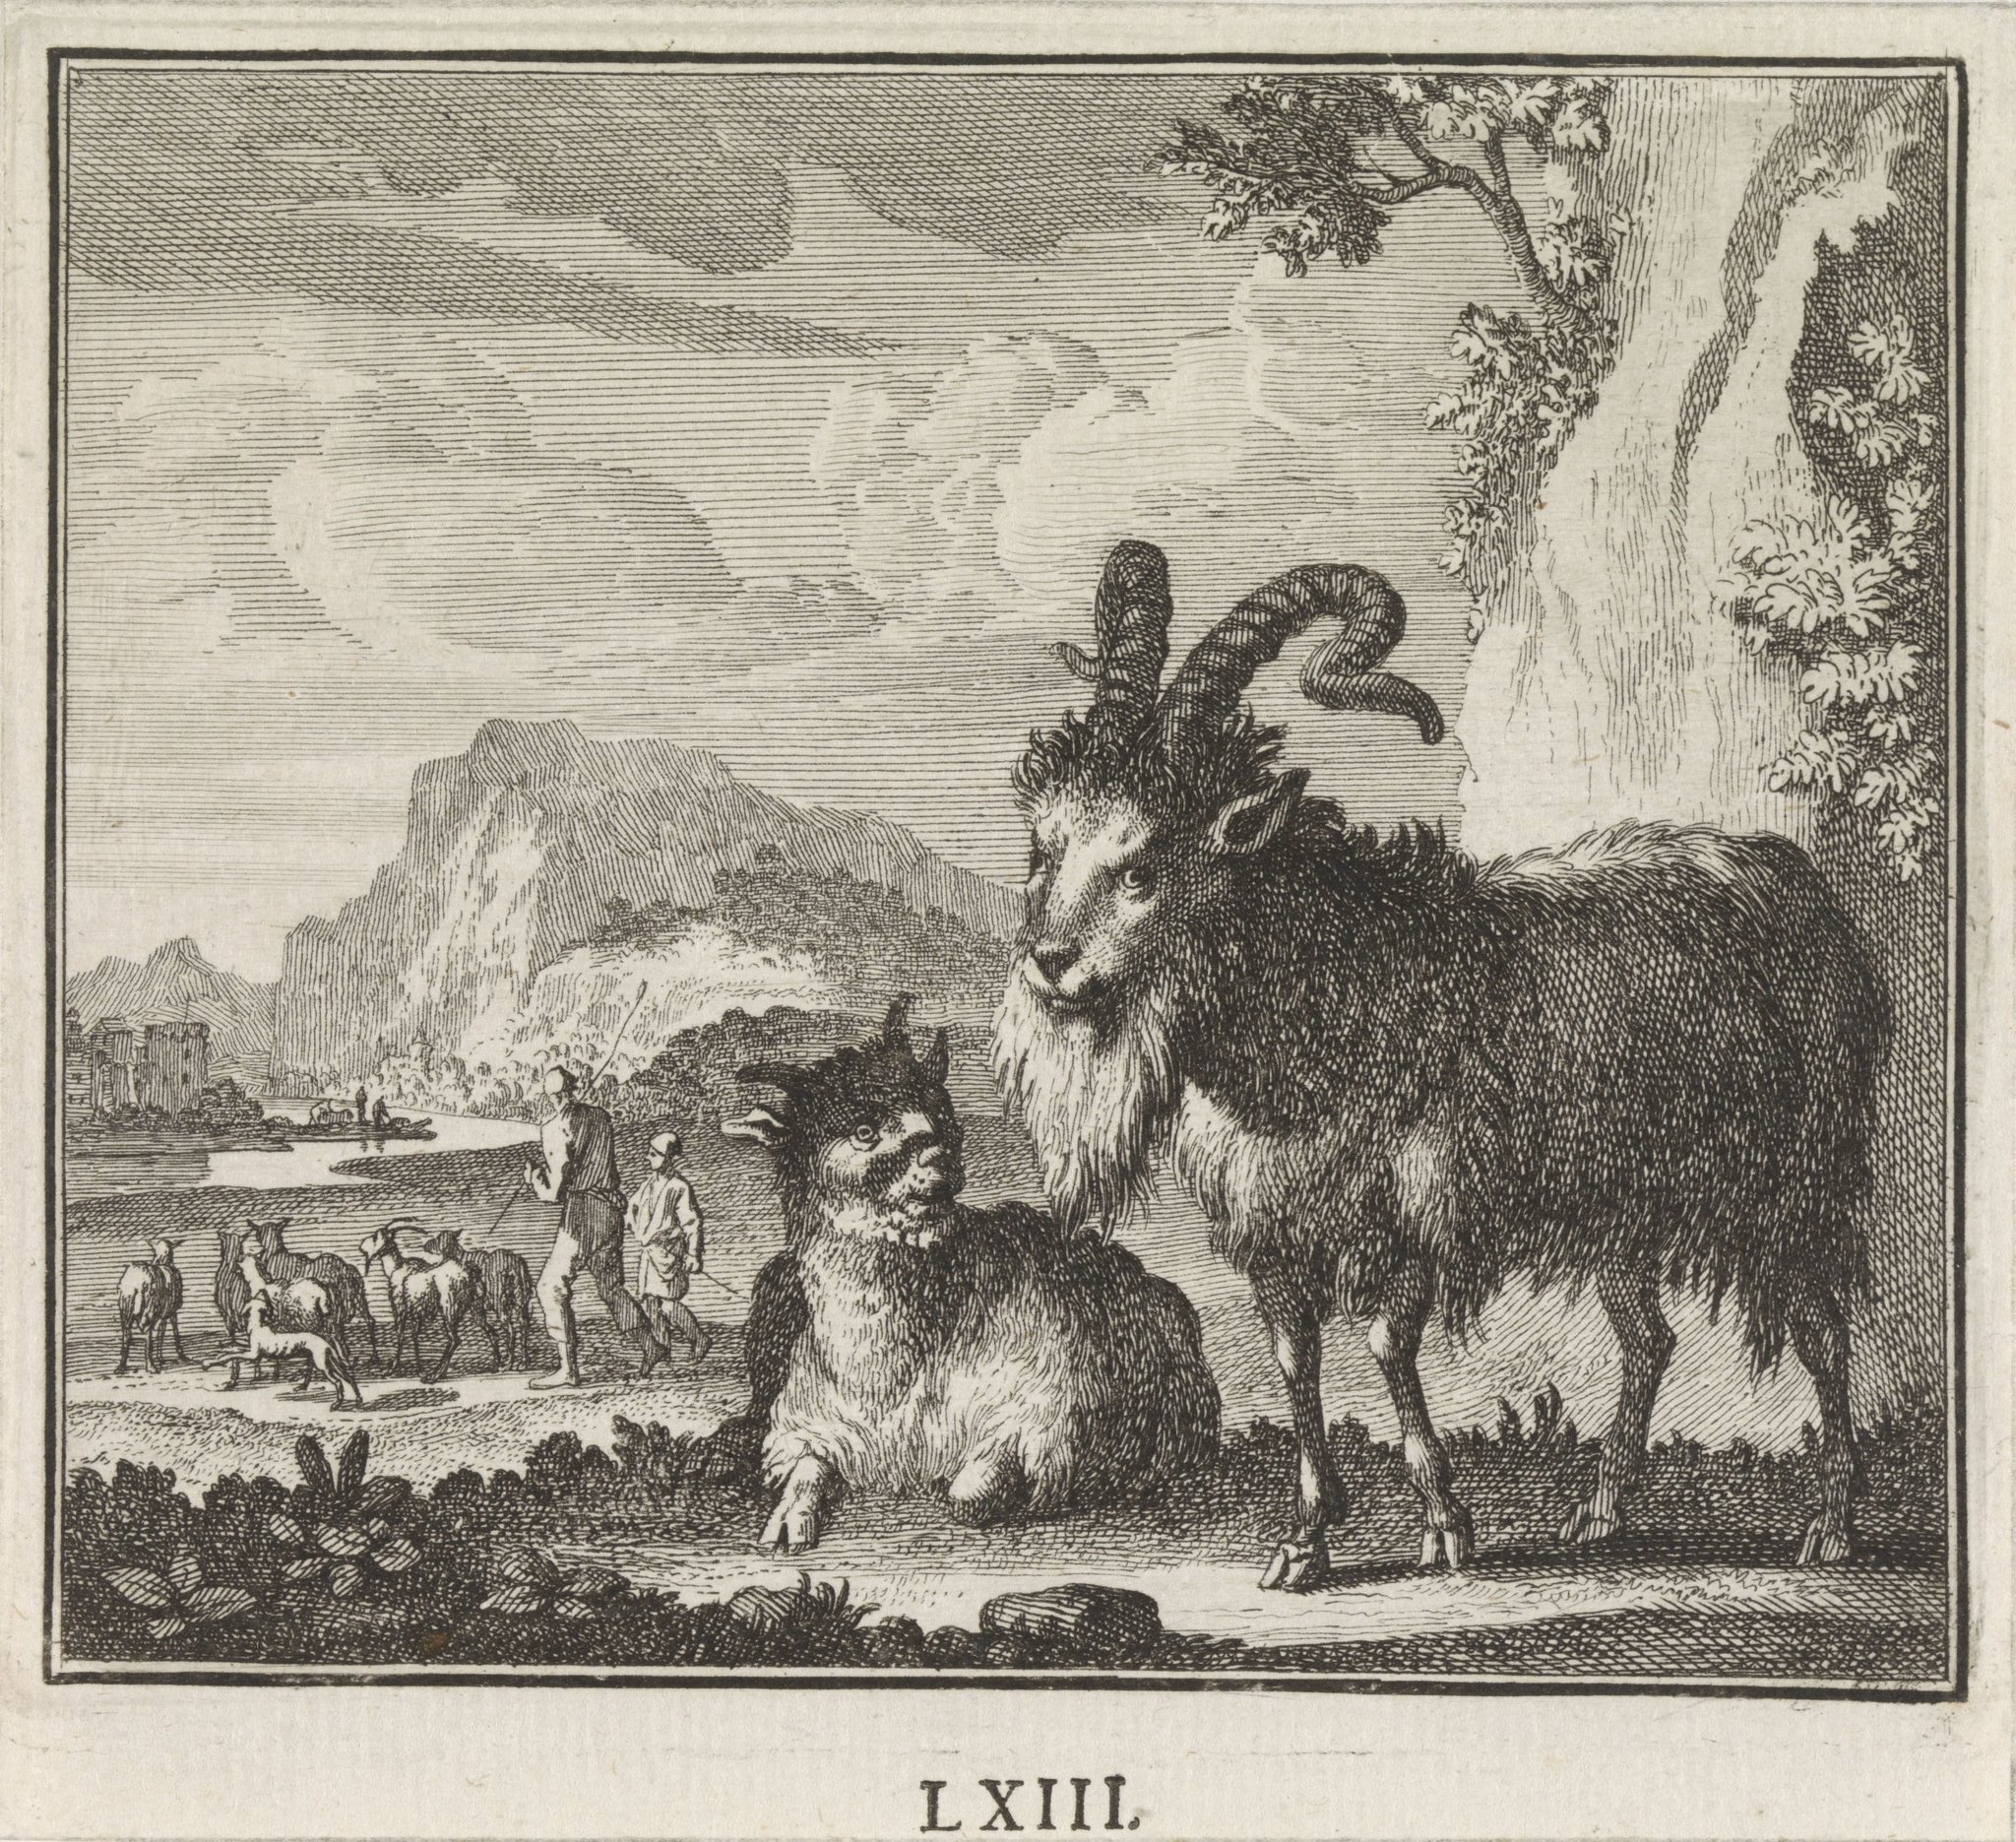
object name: book illustration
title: Bok en een geit bij steile rotswand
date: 1695-1705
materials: paper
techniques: etching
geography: nuremberg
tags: herding, herdsman, herdswoman, shepherd, shepherdess, cowherd, etc., goat, mountains, abstract ideas and concepts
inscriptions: collector's mark: Lugt 2228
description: Boekillustratie voor Weigel, Christoph. Ethica Naturalis seu Documenta Moralia e Variis rerum Naturalium proprietatibus Virtutum Vitiorumq symbolicis imaginibus collecta. Neurenberg: Christoph Weigel: c. 1700.